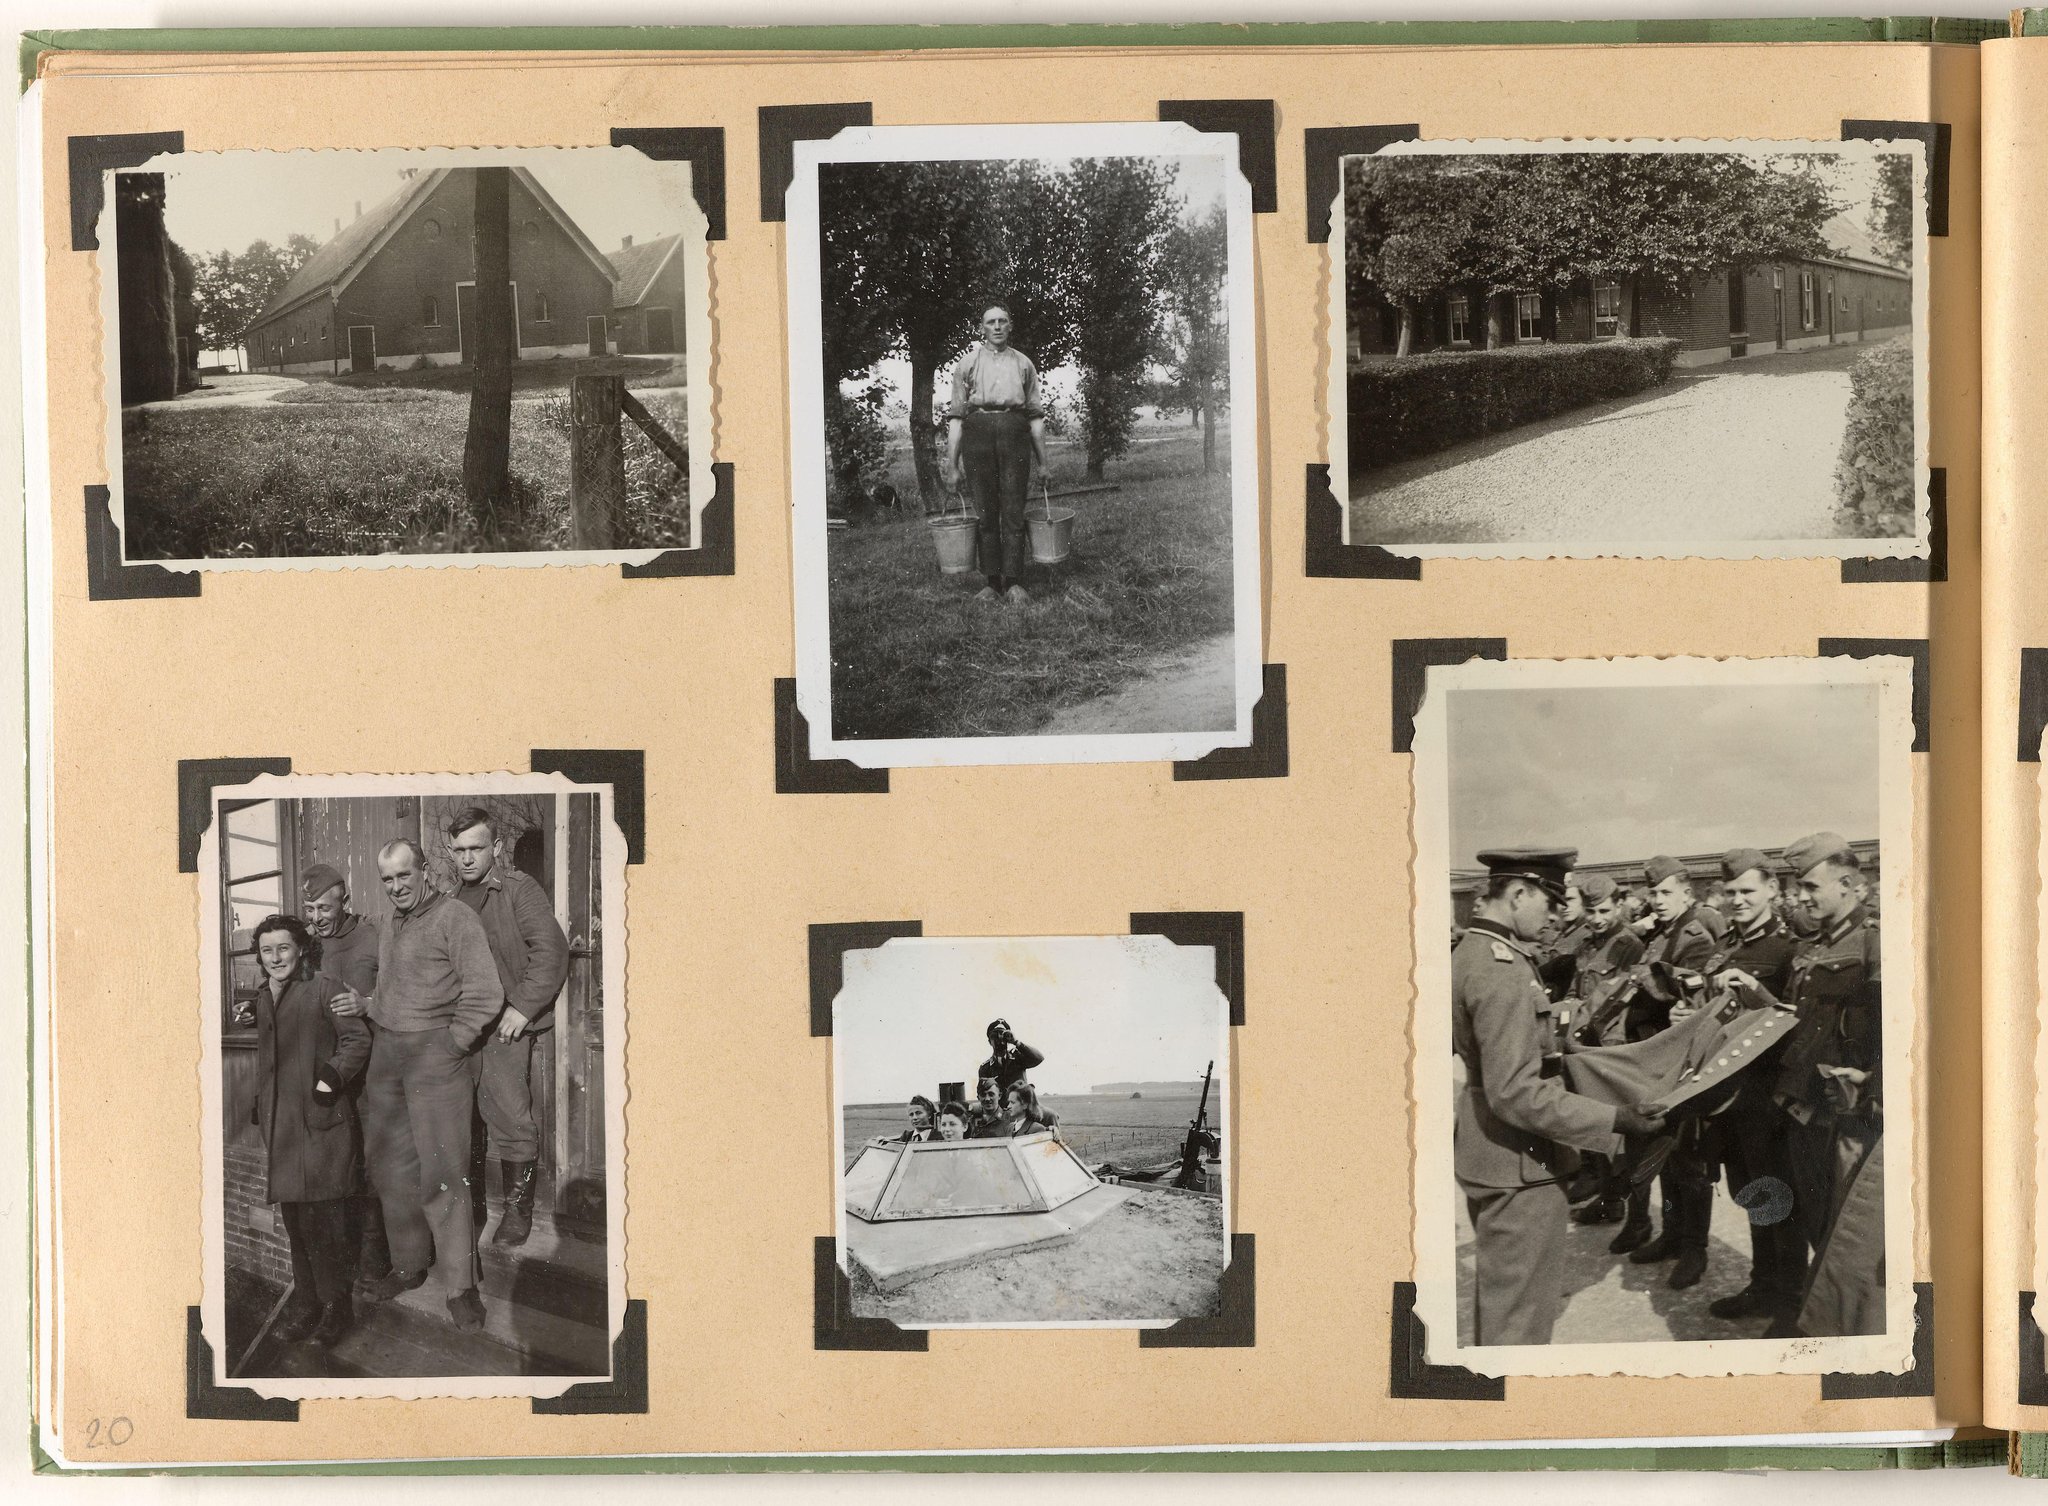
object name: photograph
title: Boerderij en uitkijk van een bunker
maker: Anonymous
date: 1940-1944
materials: paper, photographic support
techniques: gelatin silver print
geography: netherlands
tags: the company, the unit, the troop ~ military service, review, inspection (of company, unit, troop), permanent fortifications, farm (building), netherlands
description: Albumblad met zes foto's. Drie foto's van een Nederlandse boerderij en een boerenjongen met twee emmers, drie Duitse militairen met een vrouw, vijf Duitse militairen, waarvan drie vrouwen, in de uitkijk van een bunker en van een officier en soldaten die een uniformjas bekijken. Onderdeel van het fotoalbum Bewaking bunkers.